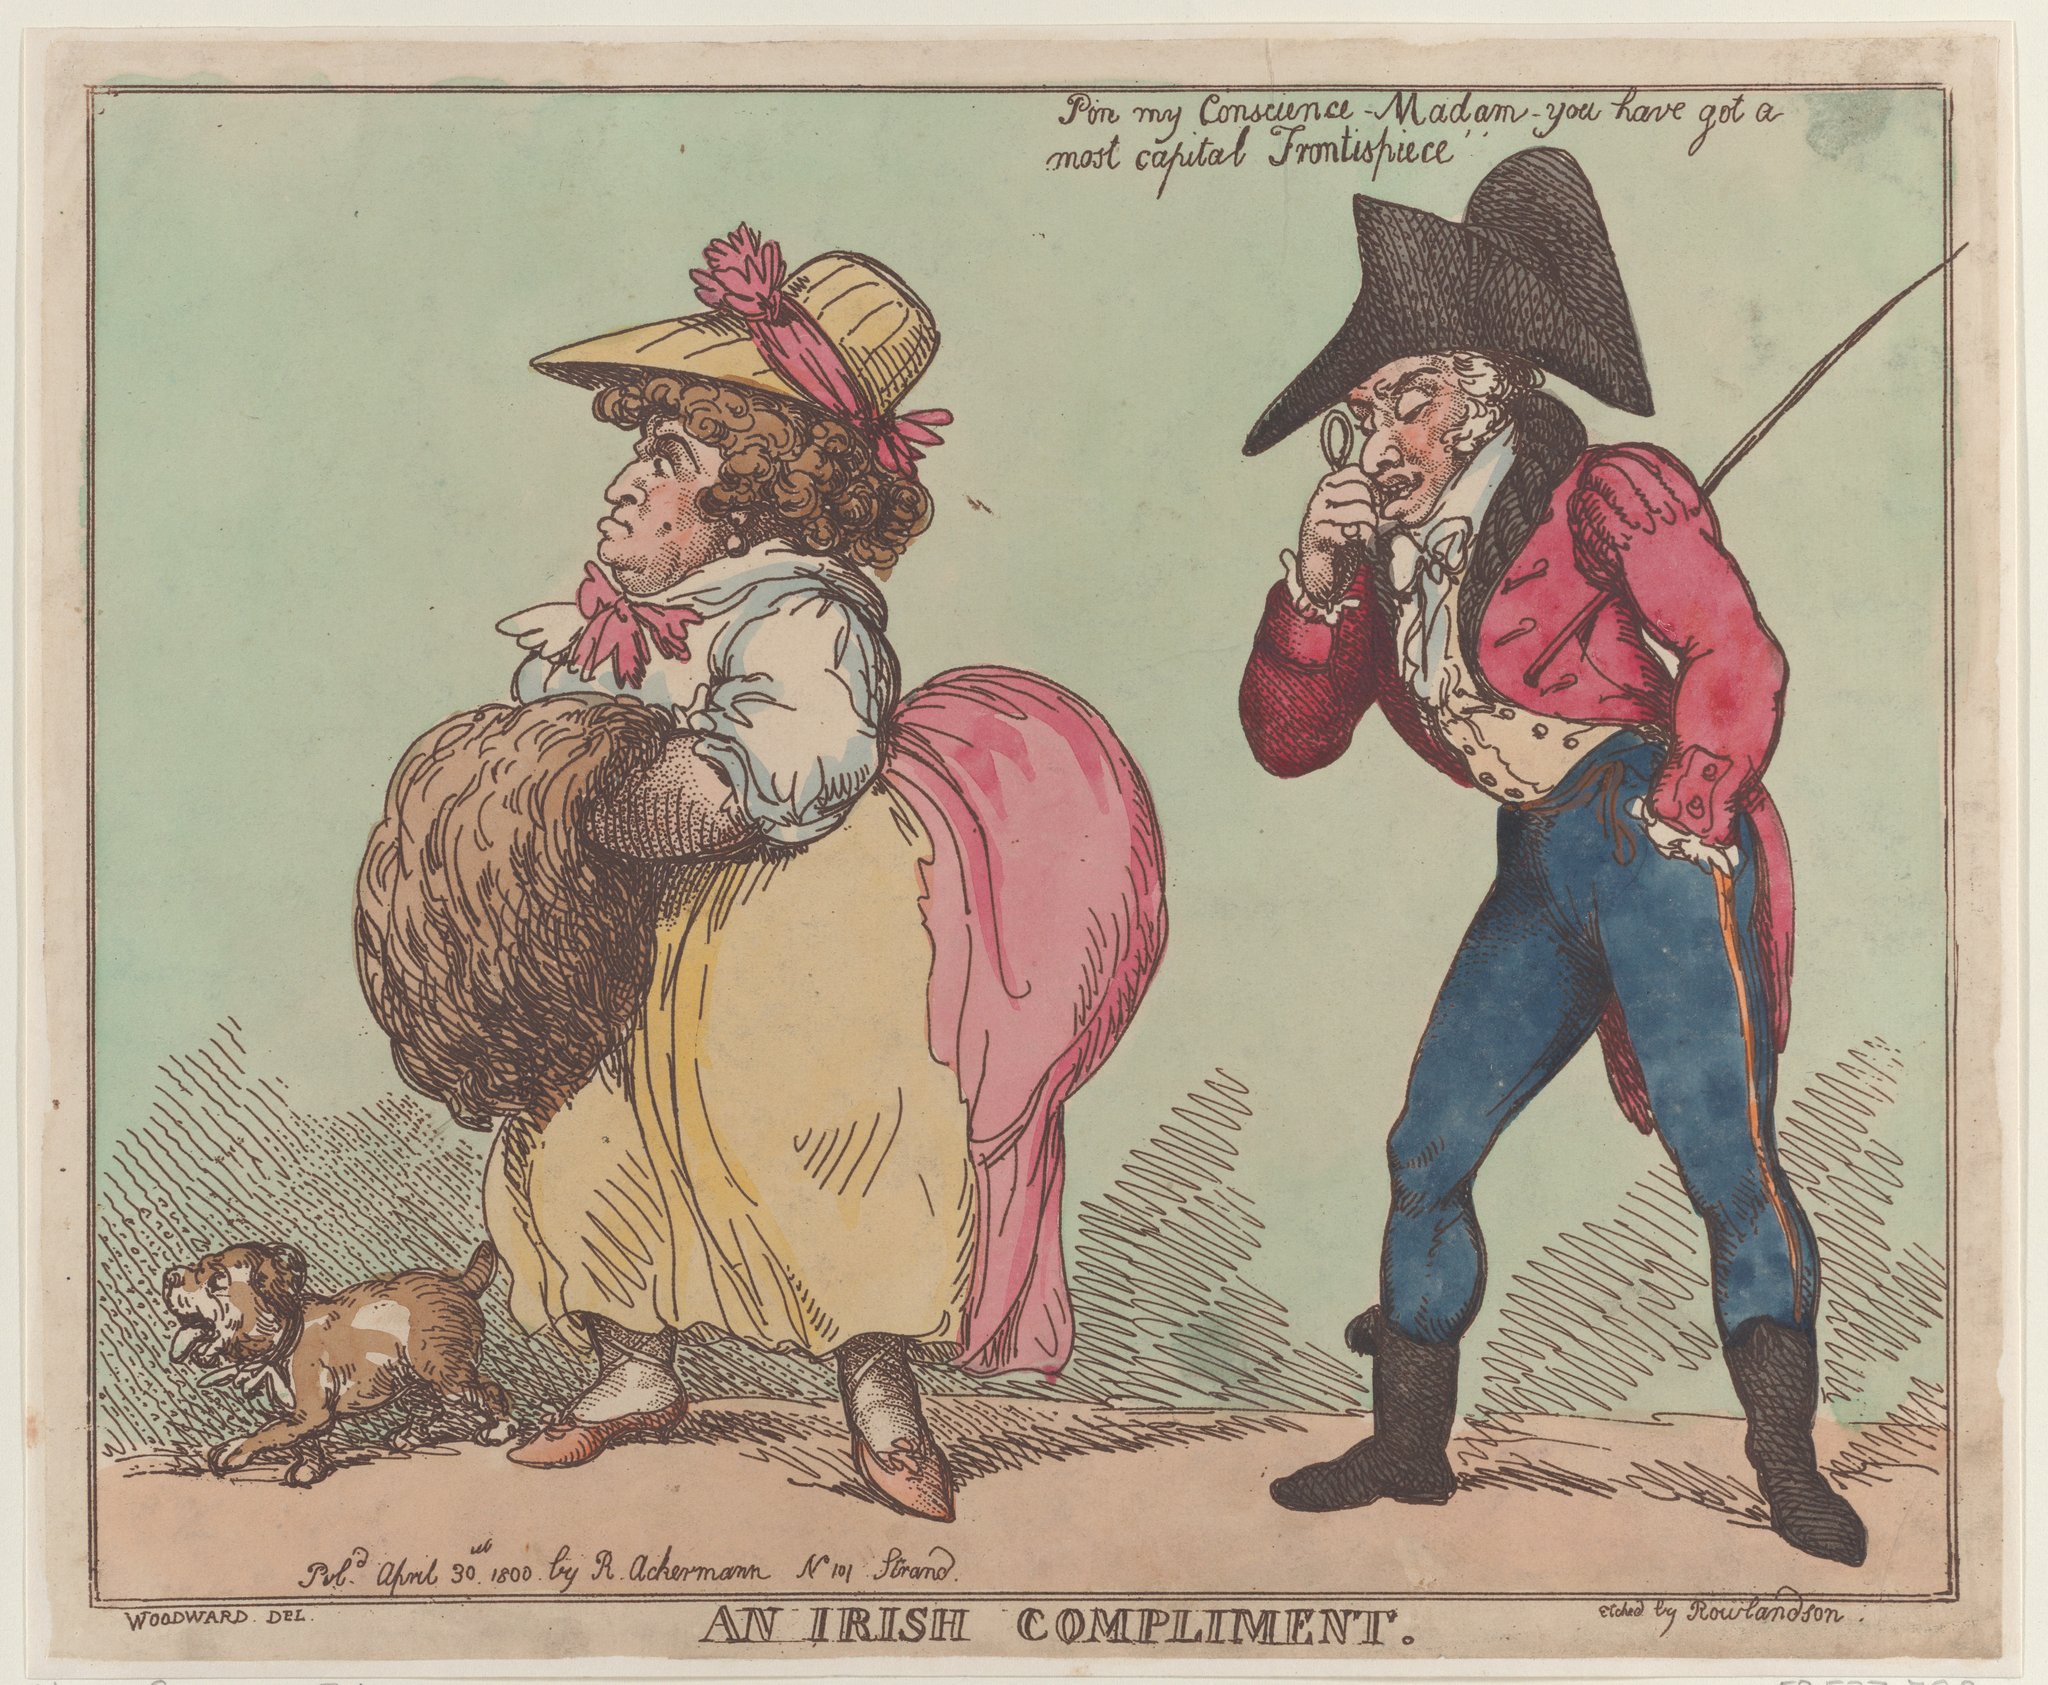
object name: print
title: An Irish Compliment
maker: thomas rowlandson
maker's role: artist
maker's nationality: british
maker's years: 1757-1827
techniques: etching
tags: satire,men,women,dogs